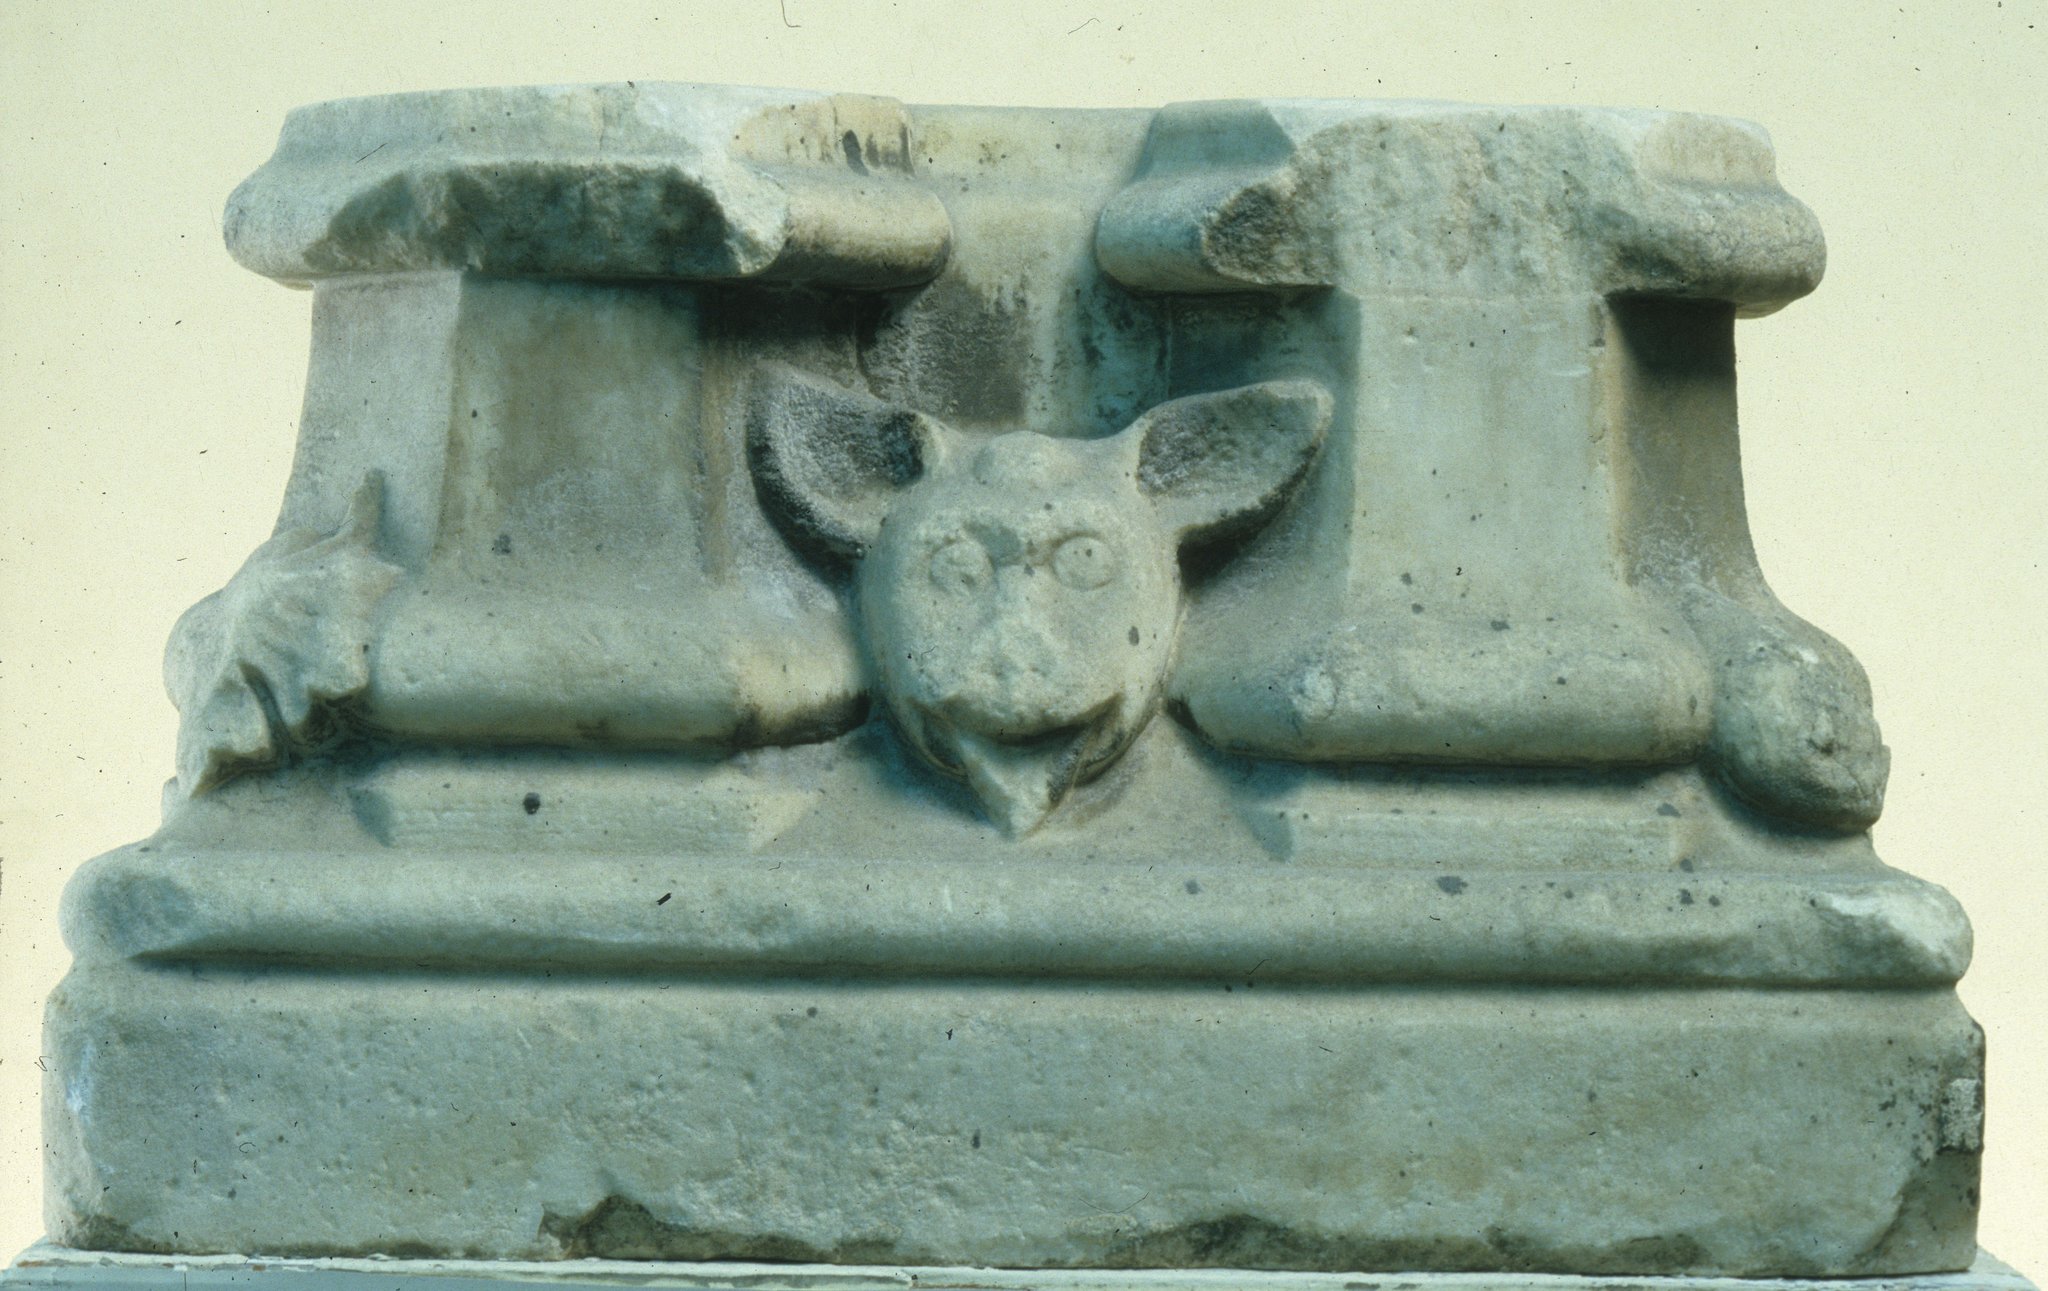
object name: base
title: Double Column Base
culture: french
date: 1467-1500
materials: marble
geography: france